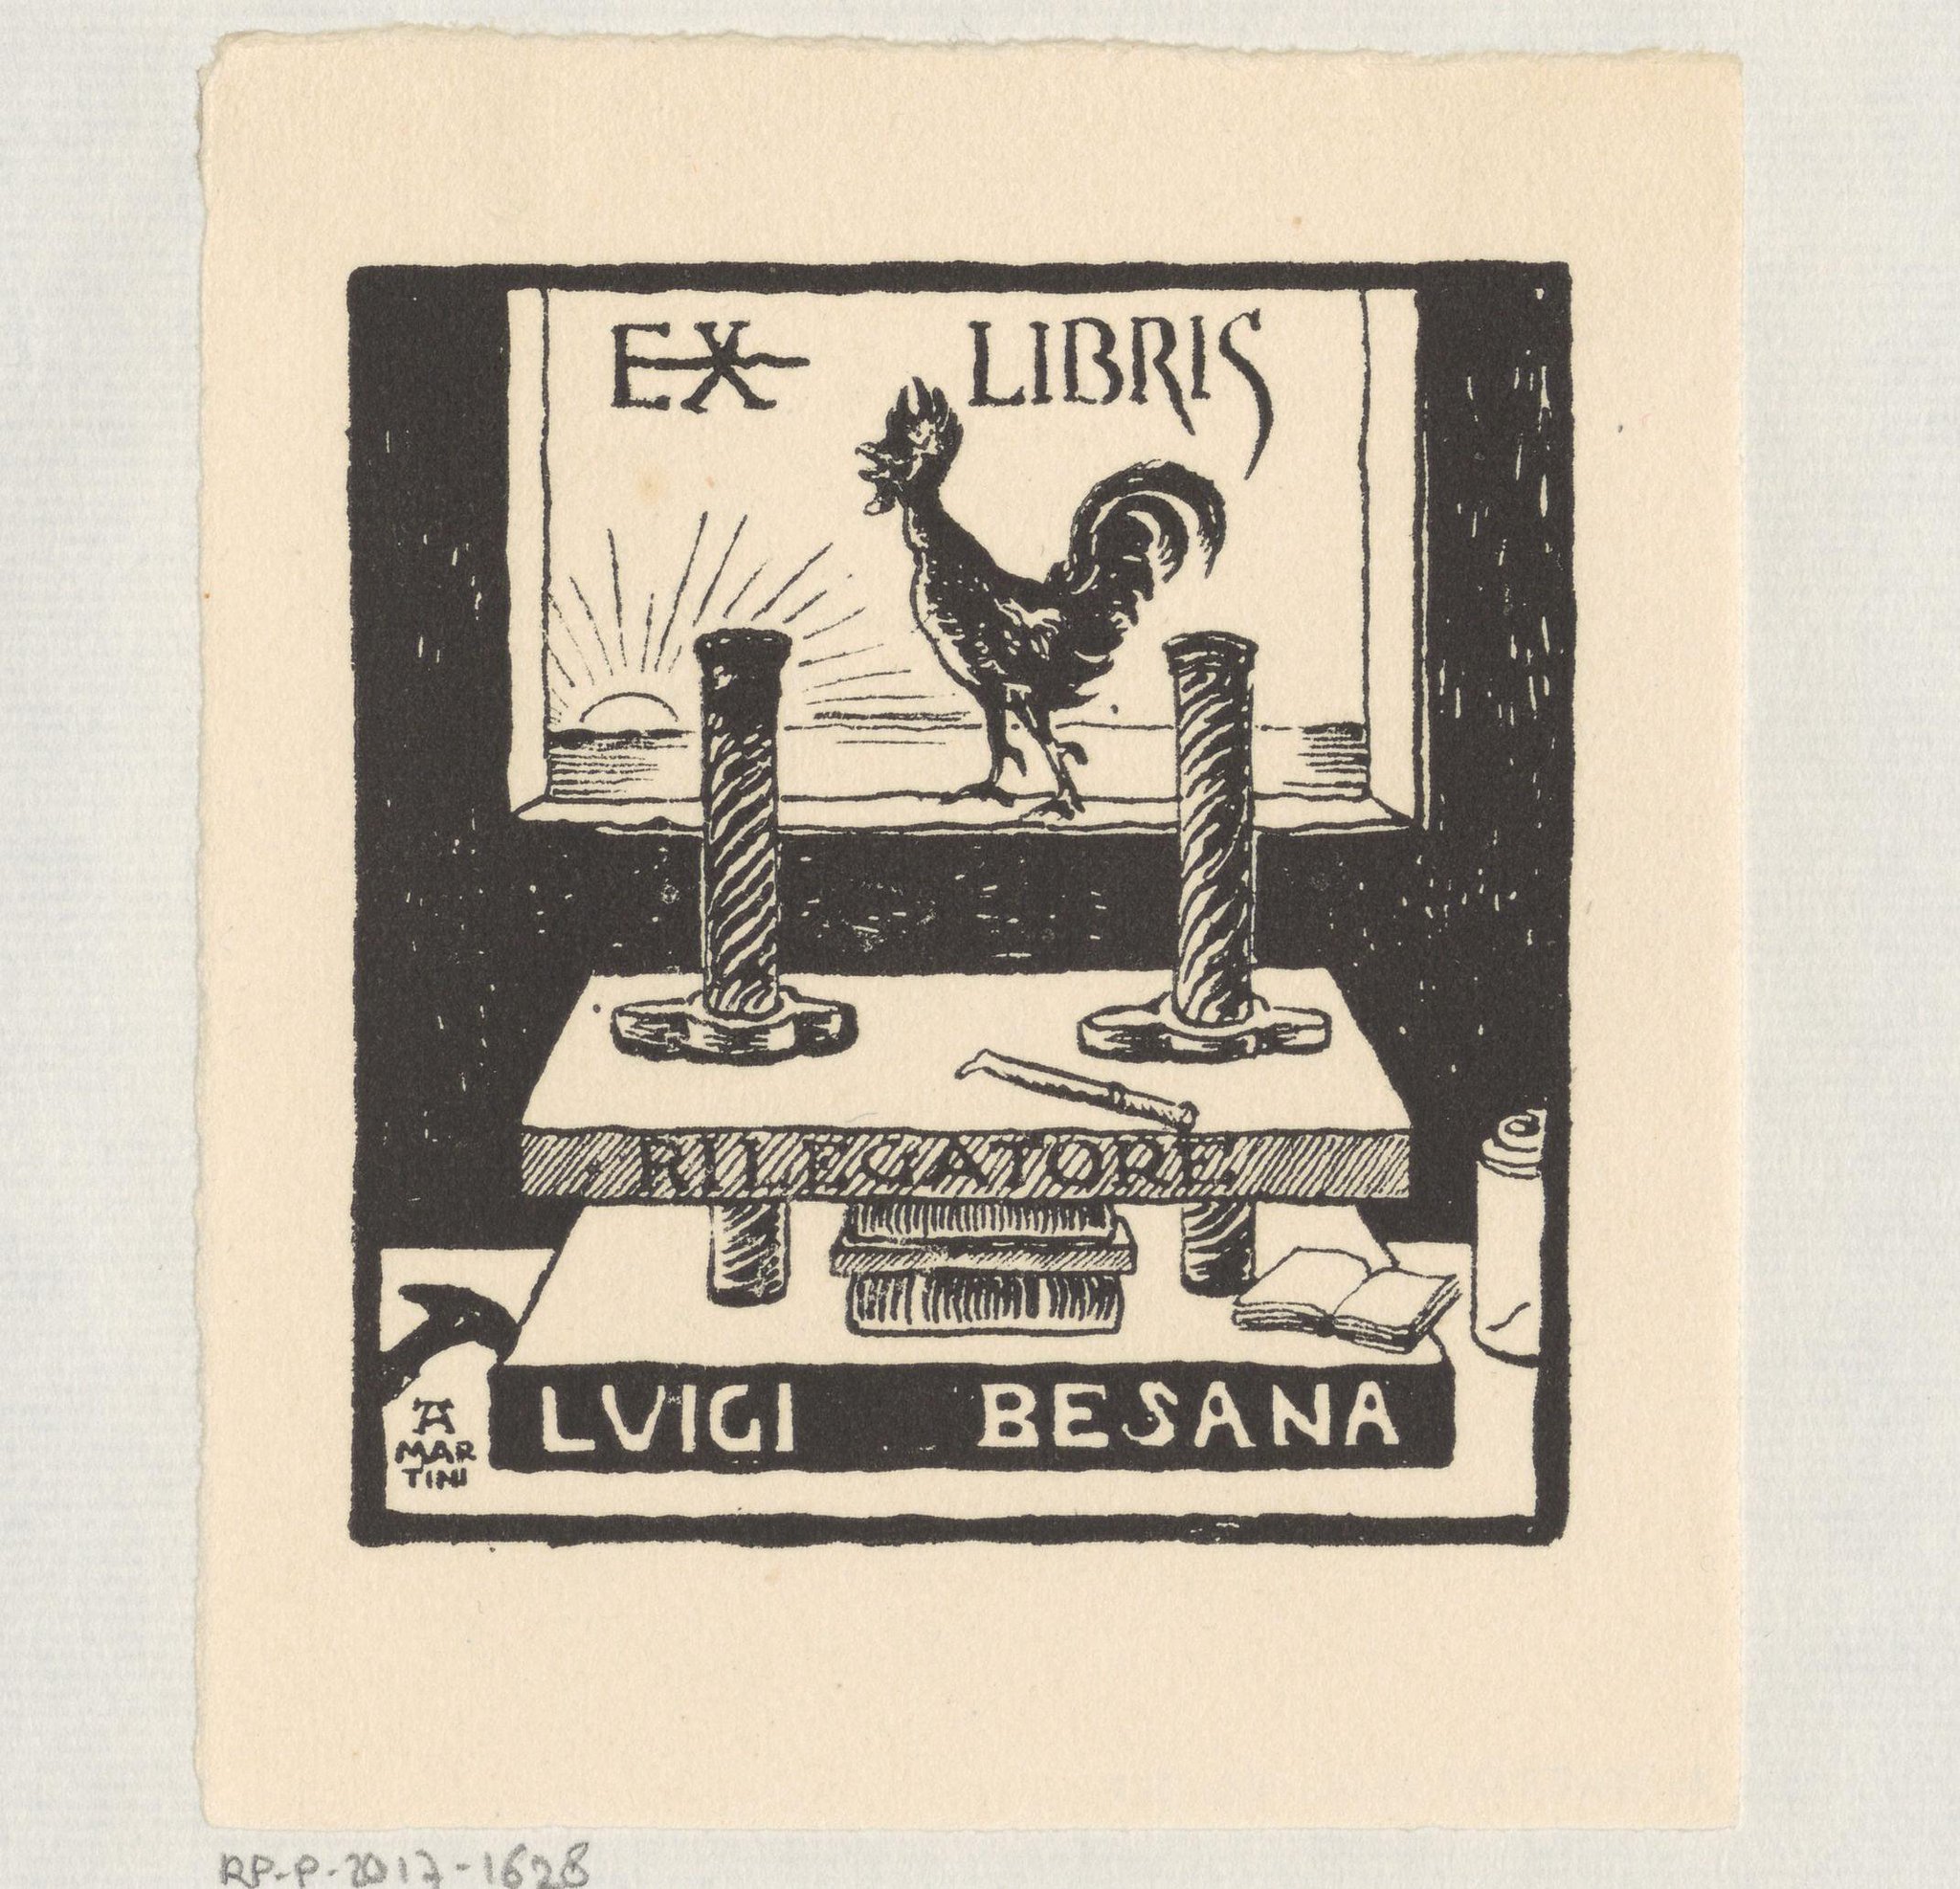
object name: bookplate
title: Ex libris van Luigi Besana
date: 1945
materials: paper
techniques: printing block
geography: italy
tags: bookbinding, book, sunrise, fowl (cock, hen, chicken, etc.)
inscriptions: workshop stamp: ‘A. Martini 1945. Cl.N. 1’